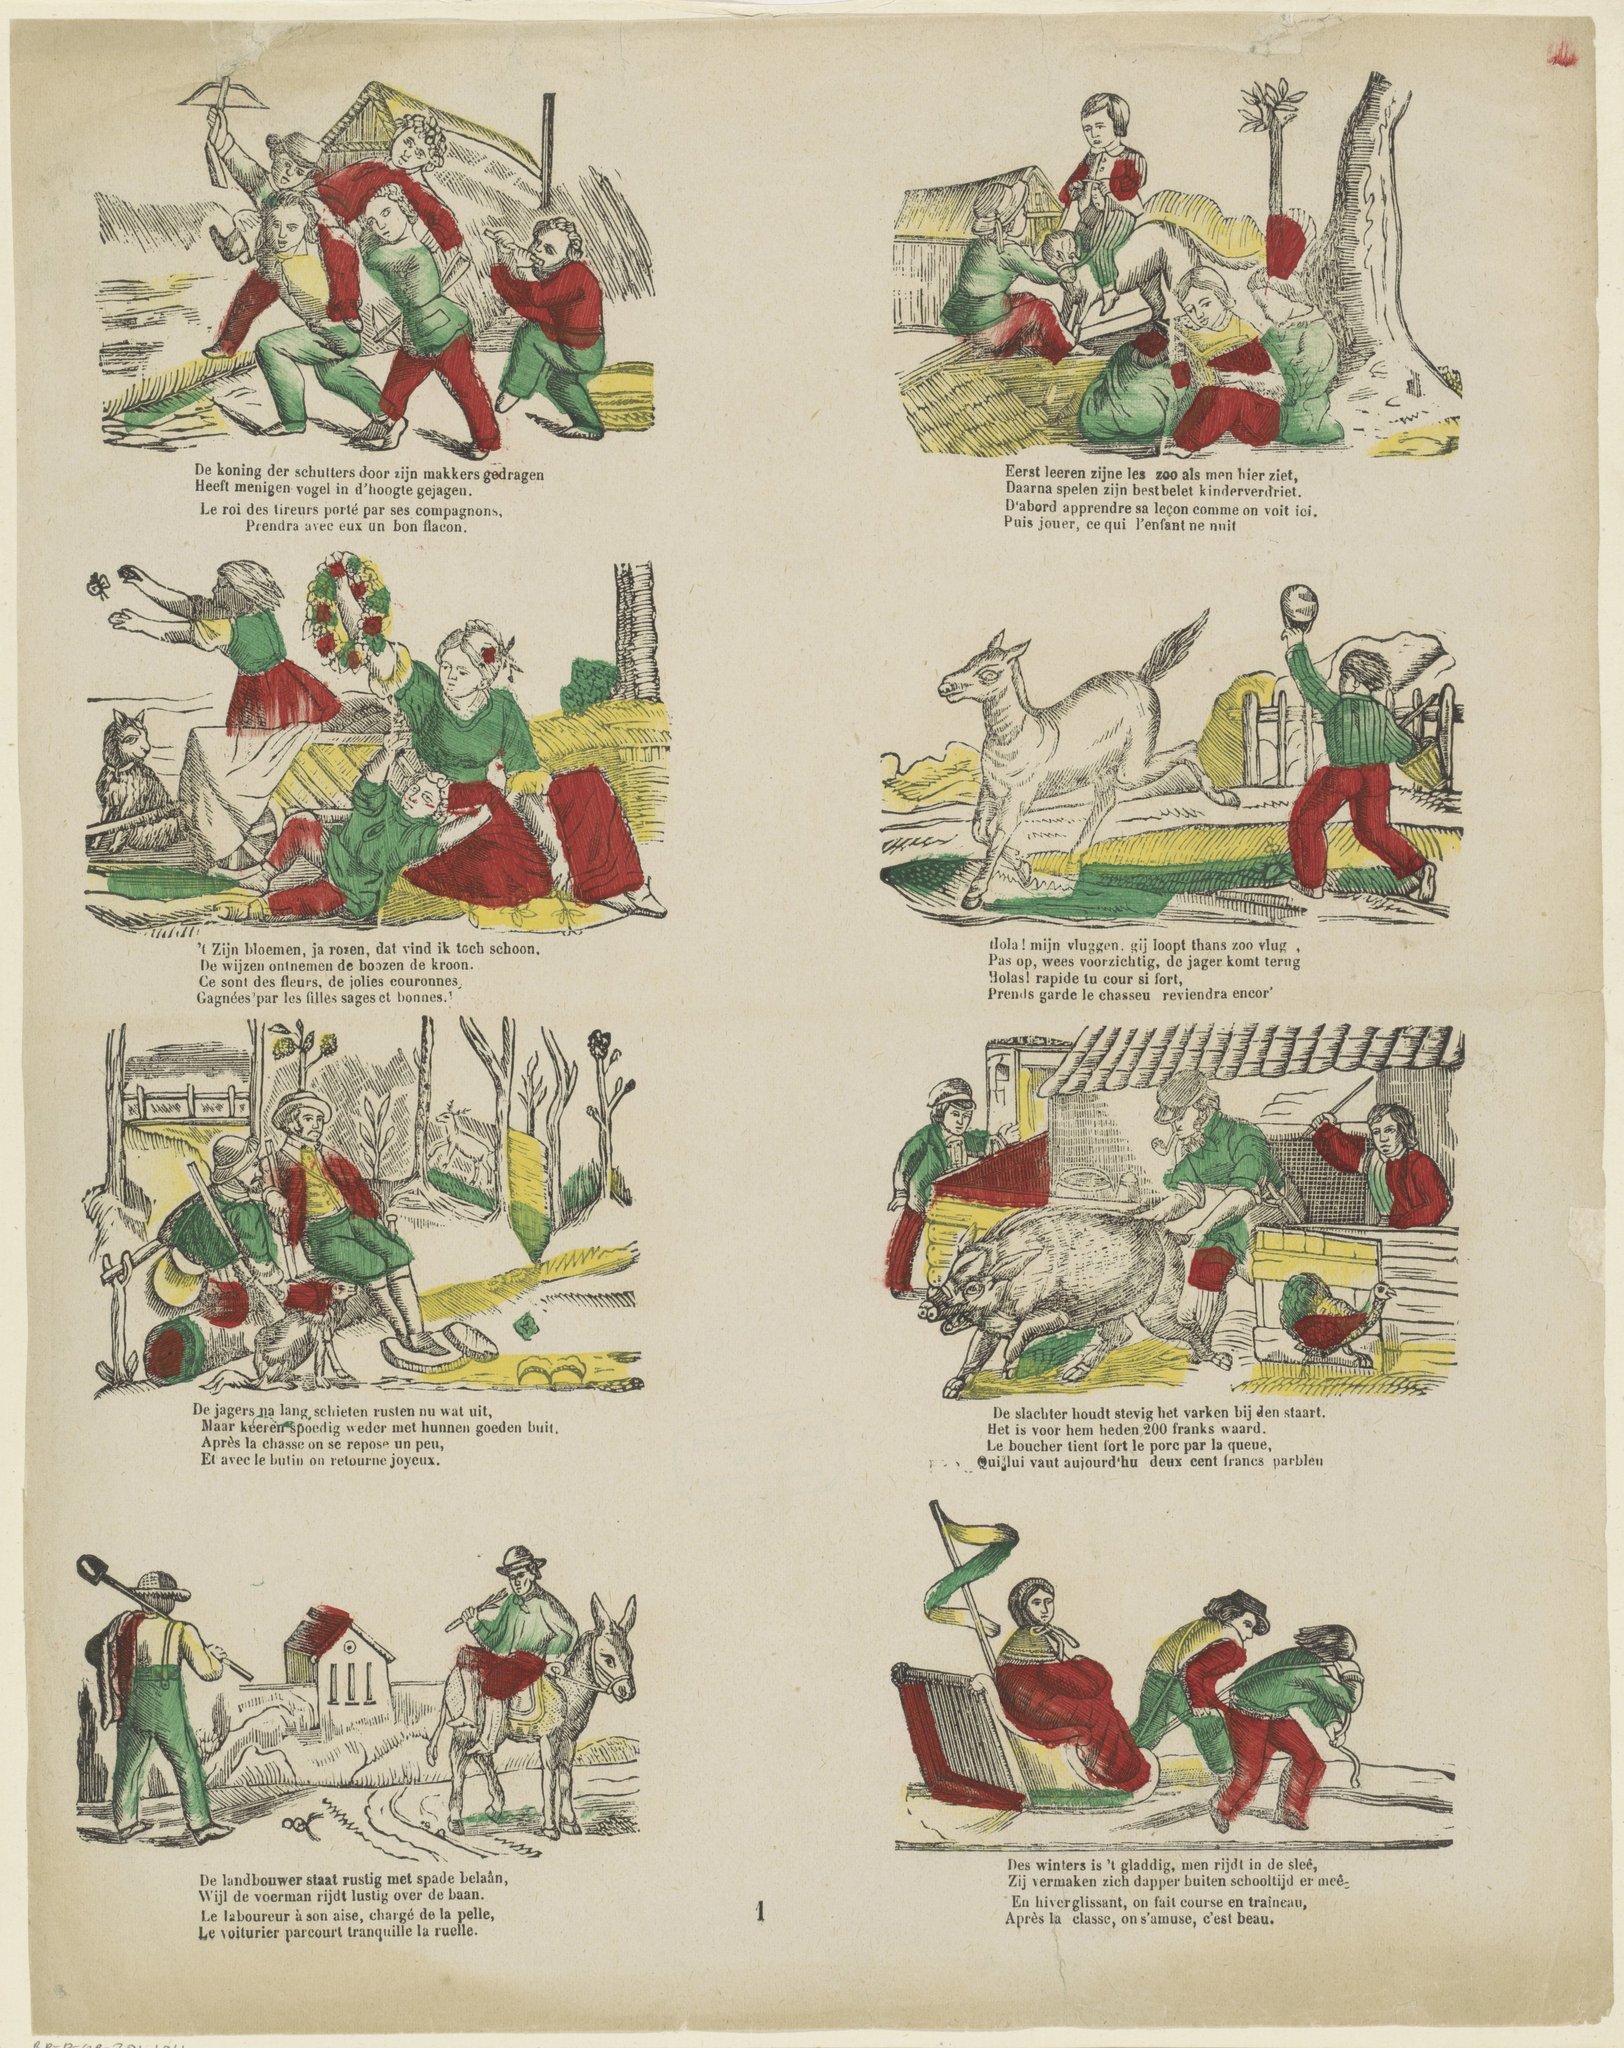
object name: popular print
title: Verschillende voorstellingen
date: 1866-1902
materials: paper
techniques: colour, letterpress printing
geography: turnhout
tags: children's games and plays, sleigh, sledge (non-sport), butcher, slaughterman, horse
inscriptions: collector's mark: Lugt 2760, collector's mark: ‘Edw. Ipers / Oever 27, / Antwerpen.’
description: Blad met 8 voorstellingen van verschillende aard, waaronder voorstellingen van een vluchtend paard, een slager die op het punt staat een varken te slachten en twee jongens die een slee met een meid vooruit trekken. Onder elke voorstelling een tweeregelig vers in het Nederlands en in het Frans. Genummerd midden onder: 1.